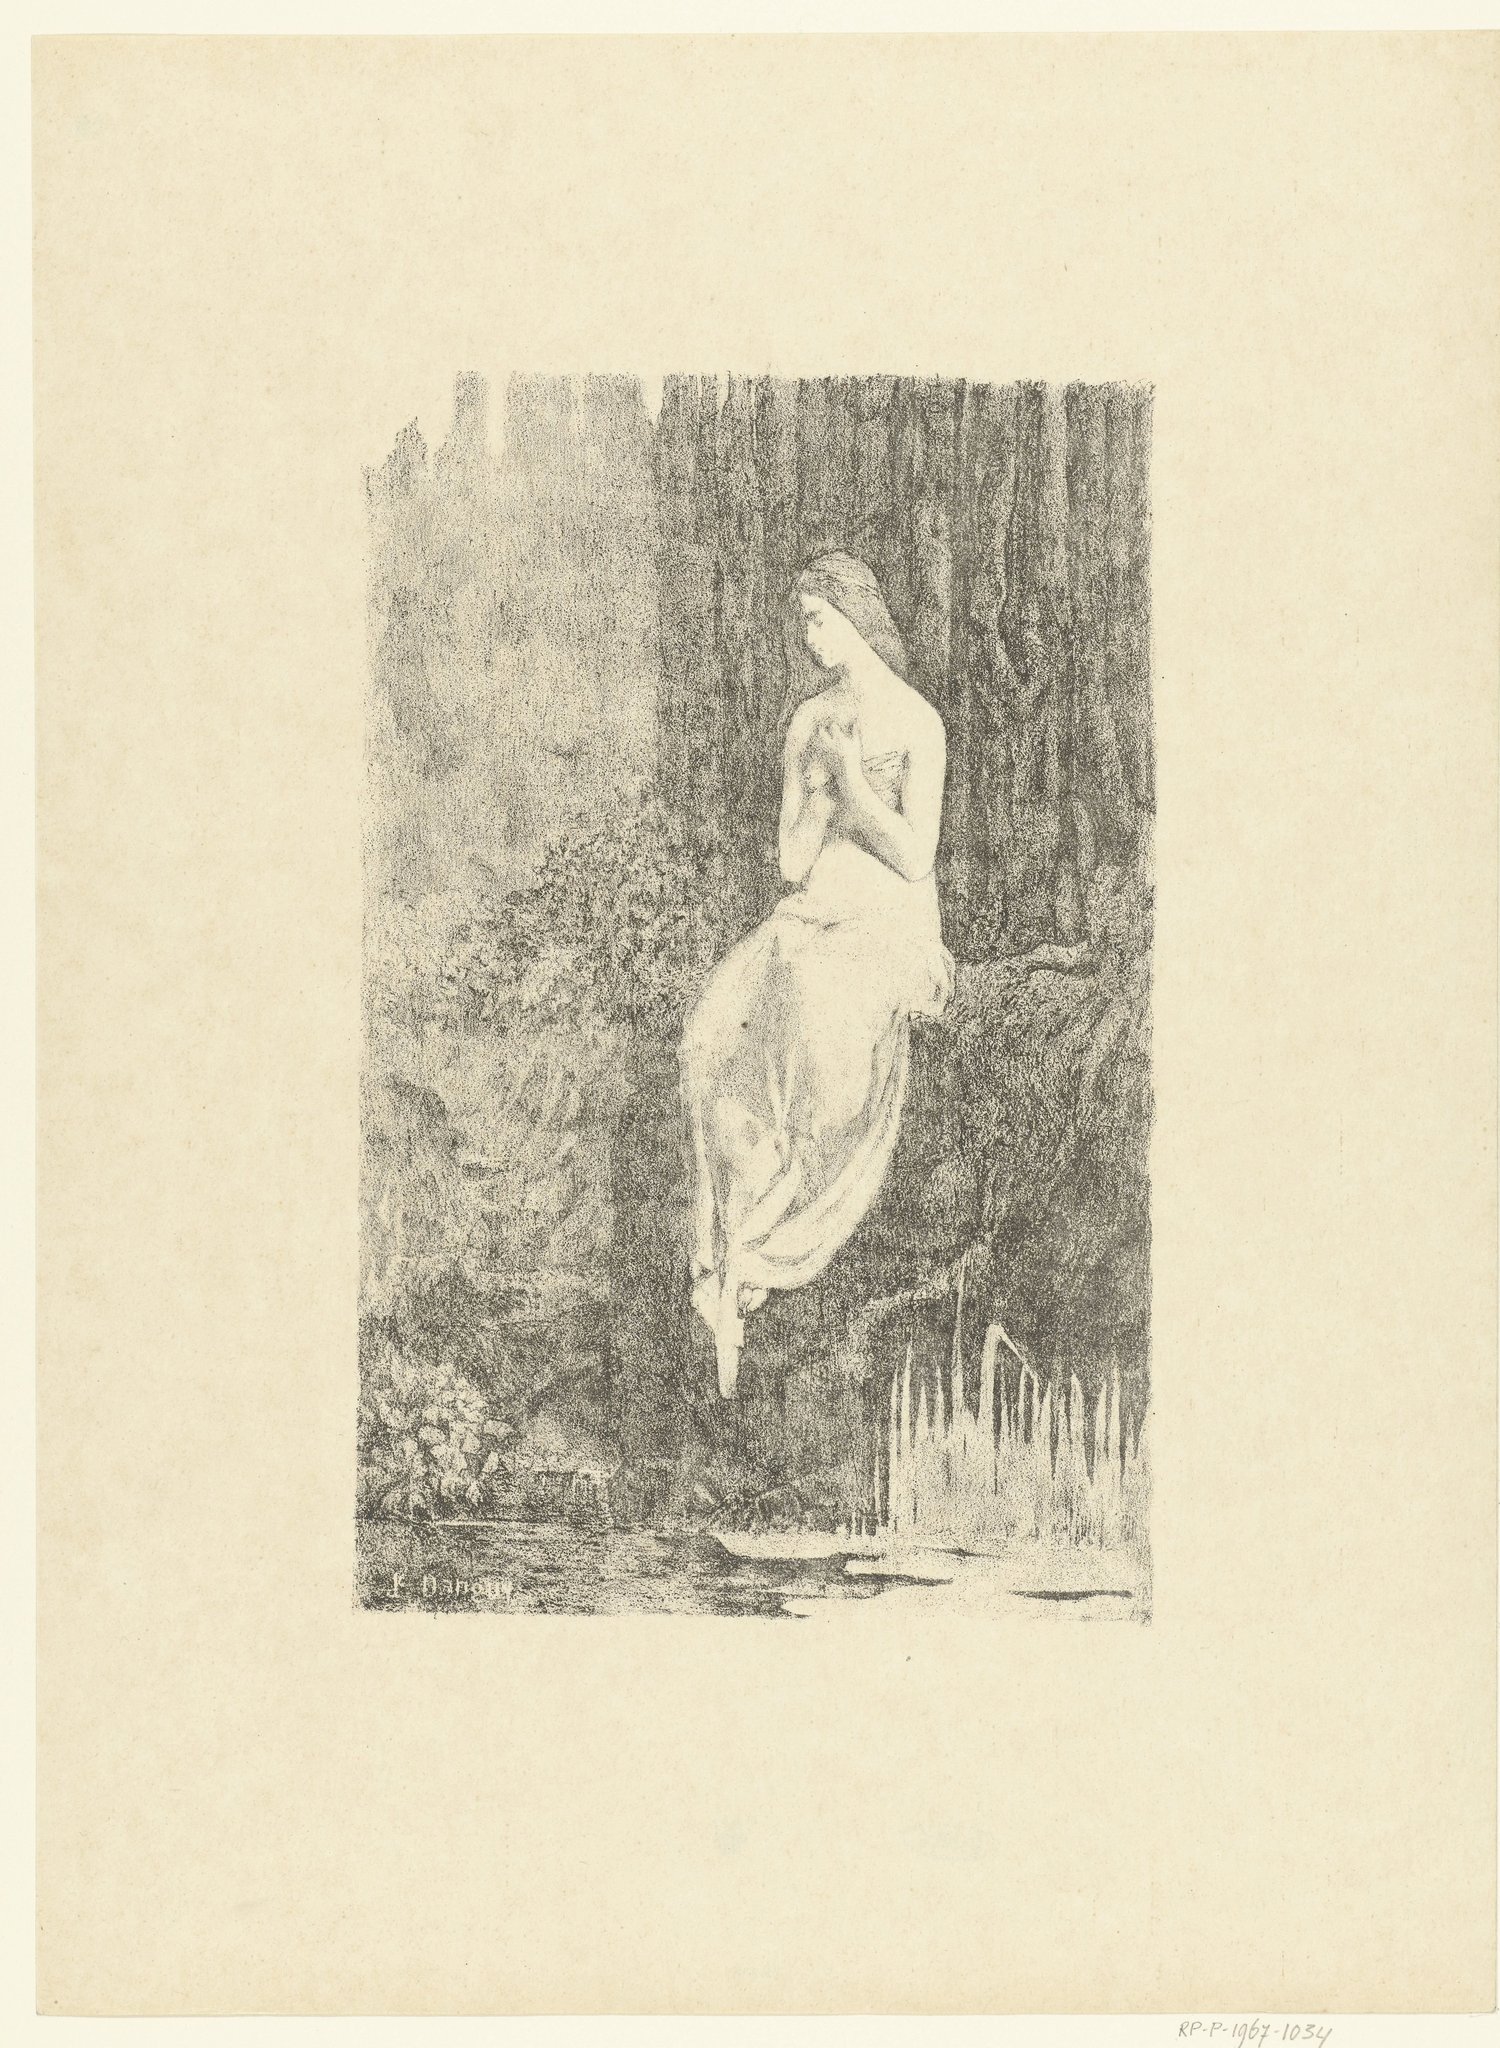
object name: print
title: Melancholie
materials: paper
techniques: lithograph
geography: paris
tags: female sex; woman, melancholic temperament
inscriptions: collector's mark: Lugt 2760, collector's mark: Lugt 2228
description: Verschenen in album met tien originele prenten bij tijdschrift: L'Epreuve, december 1894, prent nr. 5